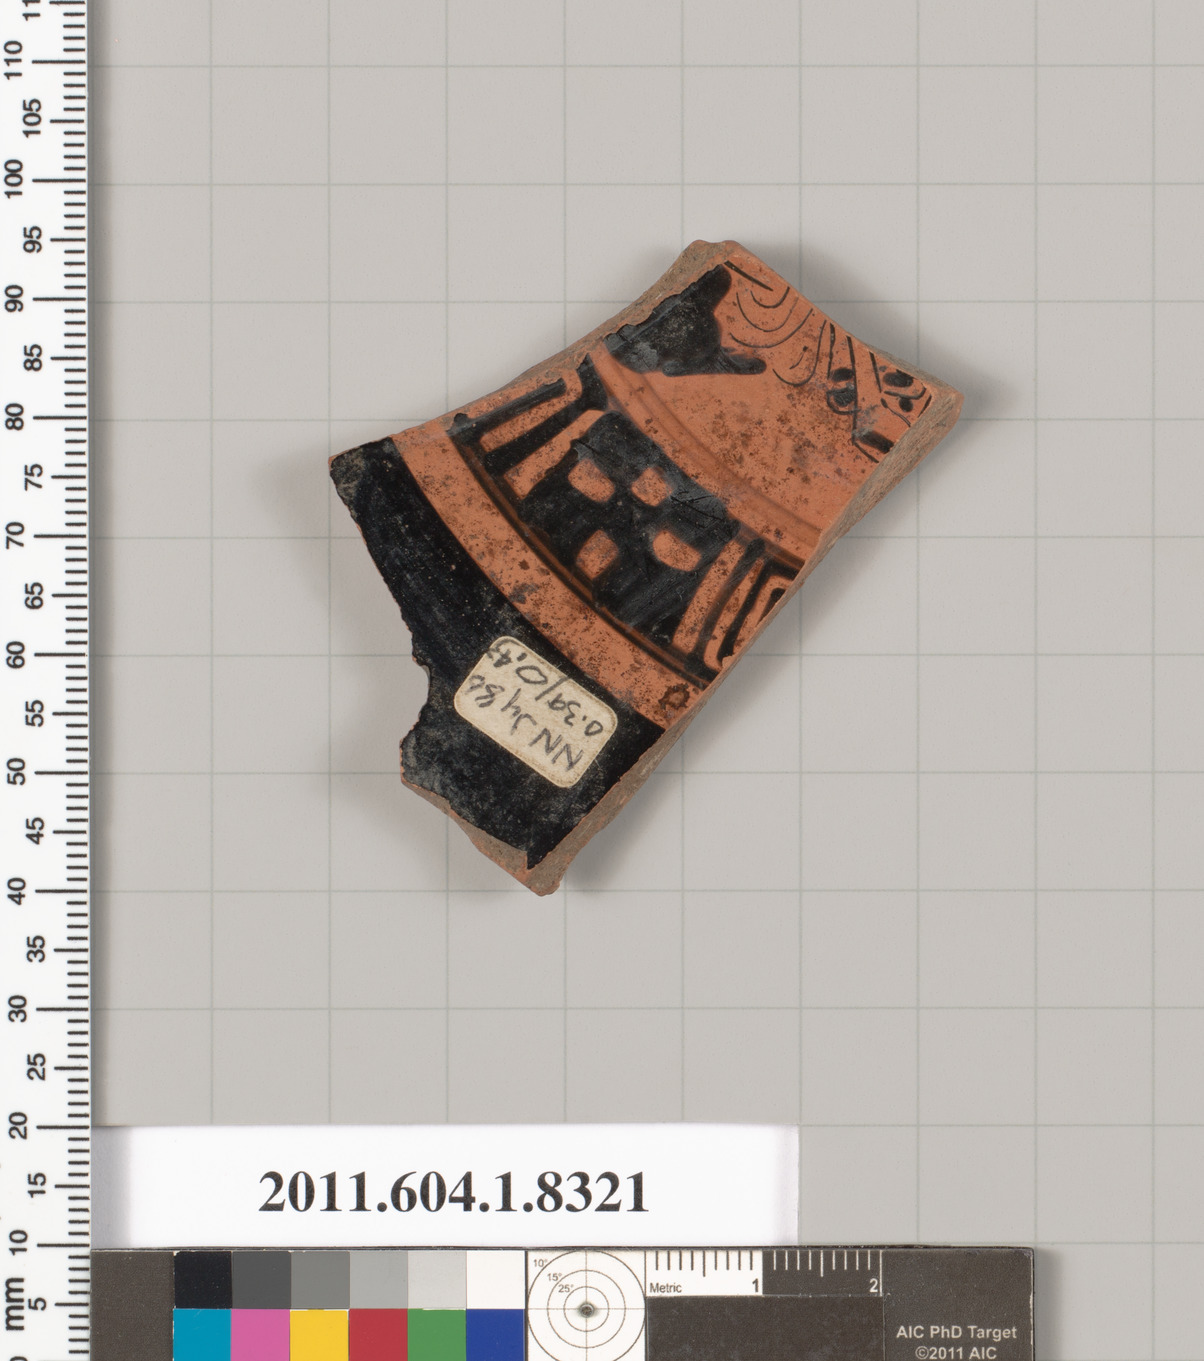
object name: kylix fragment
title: Terracotta fragment of a kylix (drinking cup)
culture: greek, attic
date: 434-368 BCE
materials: terracotta